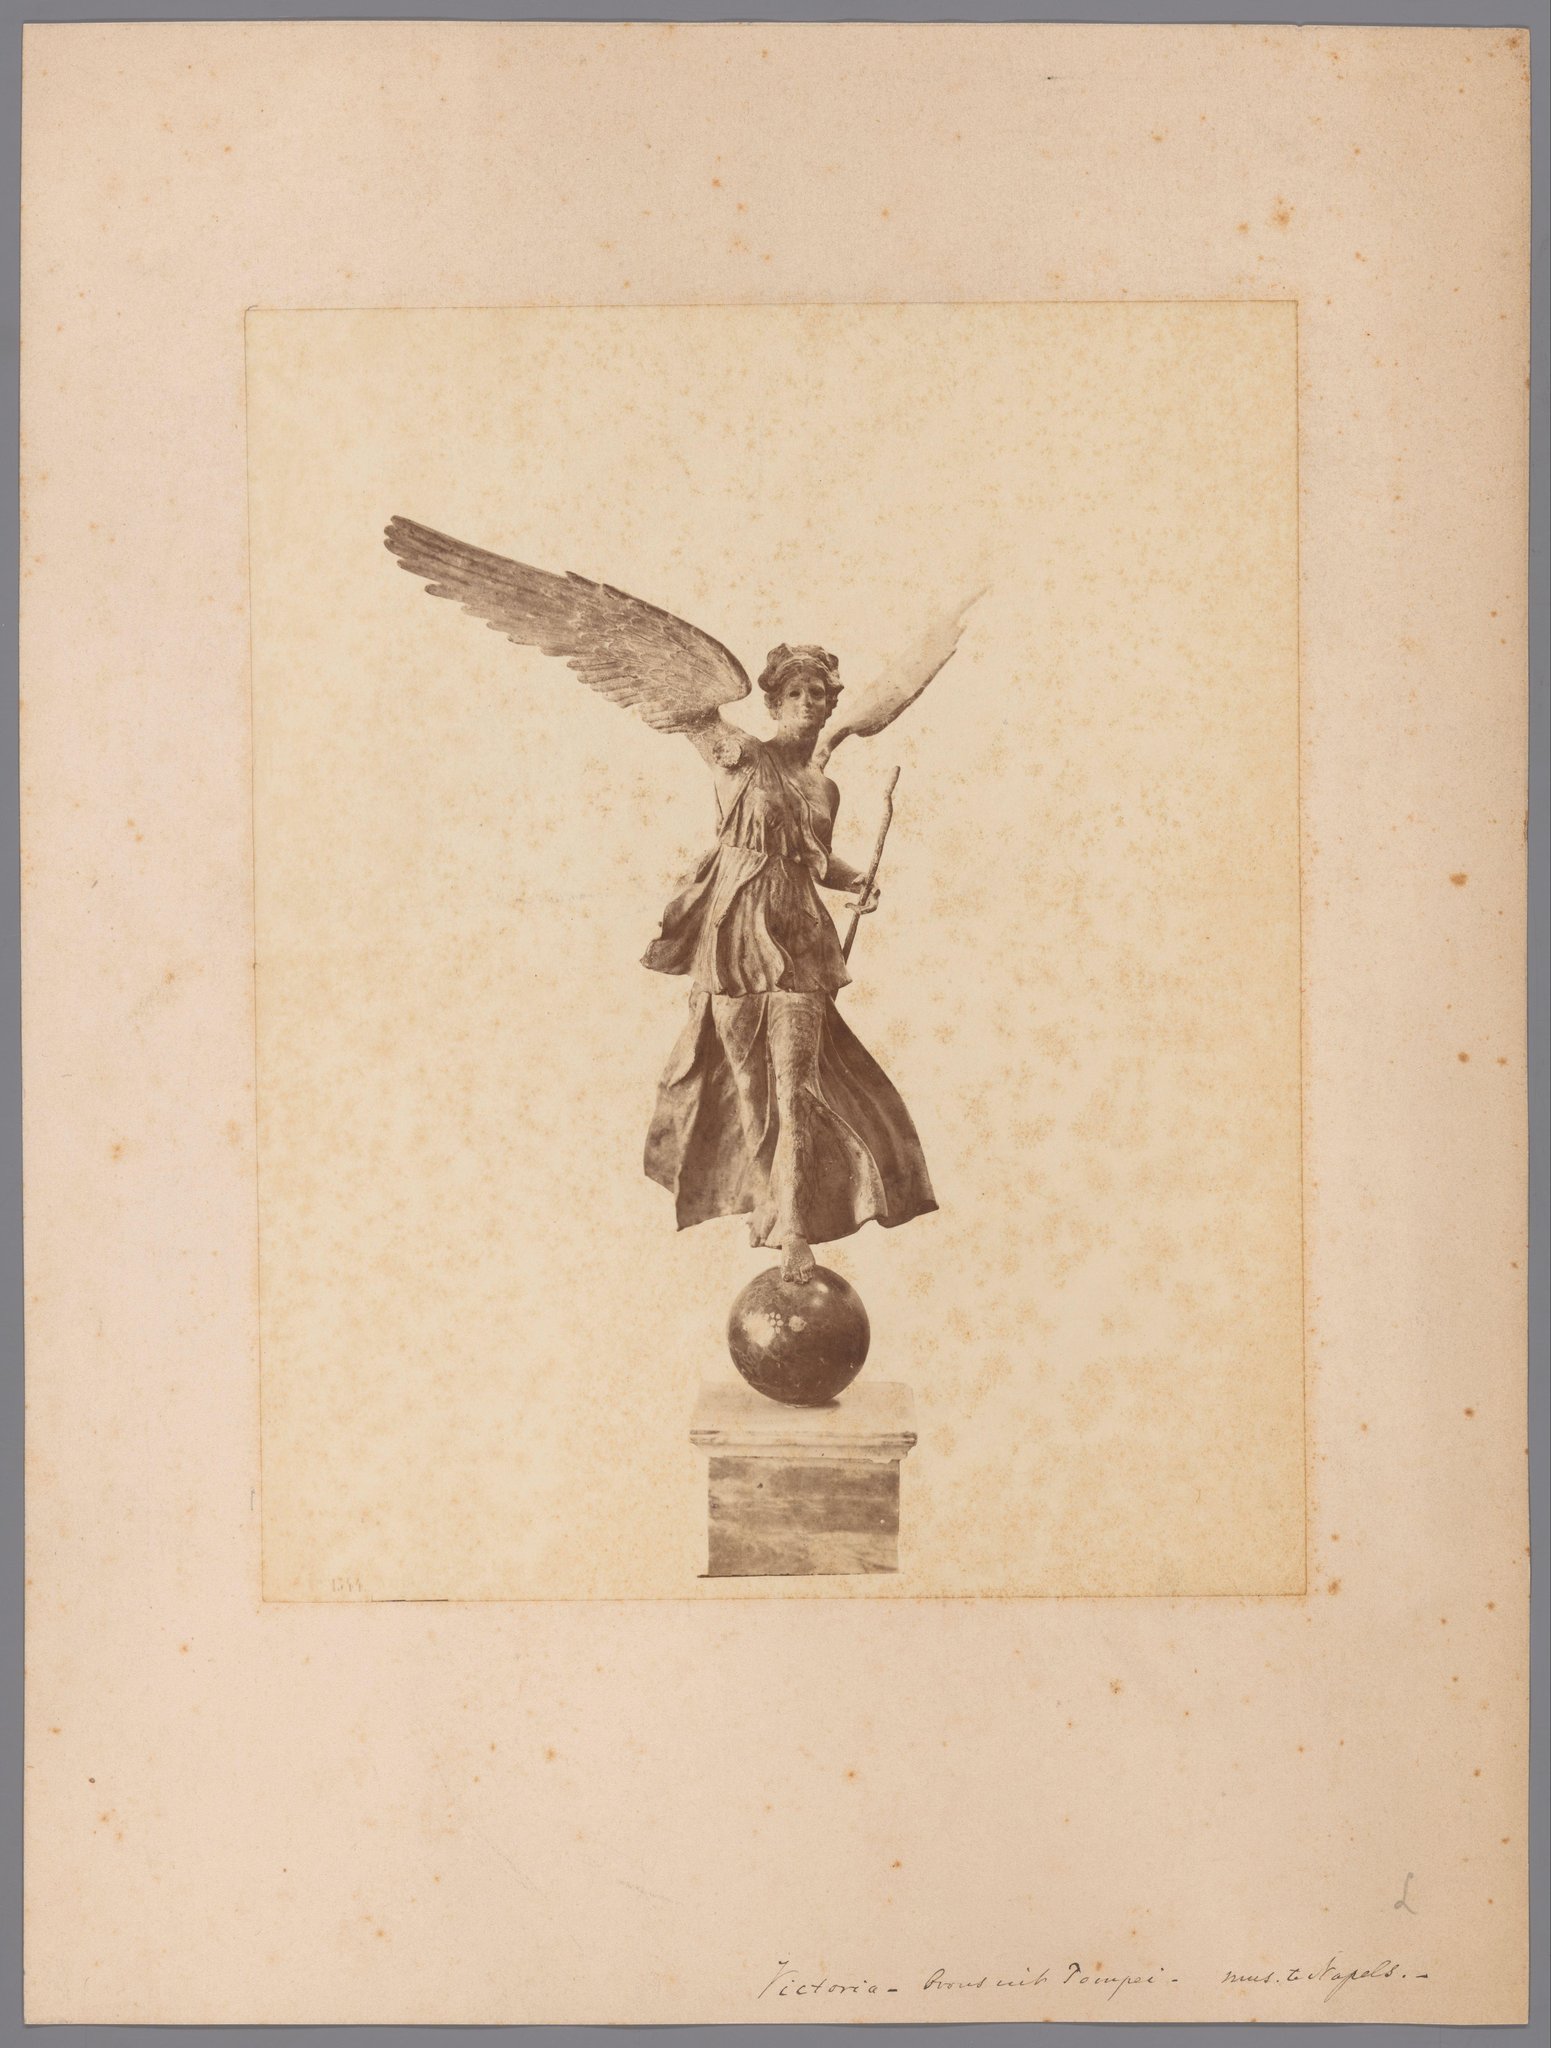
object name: photograph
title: Sculptuur van Victoria uit Pompeï in het Museo Nazionale te Napels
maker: Anonymous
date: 1860-1890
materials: cardboard, paper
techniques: albumen print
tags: victoria as roman personification, piece of sculpture, reproduction of a piece of sculpture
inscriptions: inscription: ‘Victoria - brons uit Pompei - mus. te Napels.’, collector's mark: ‘VOSMAER’, number: ‘1344.’